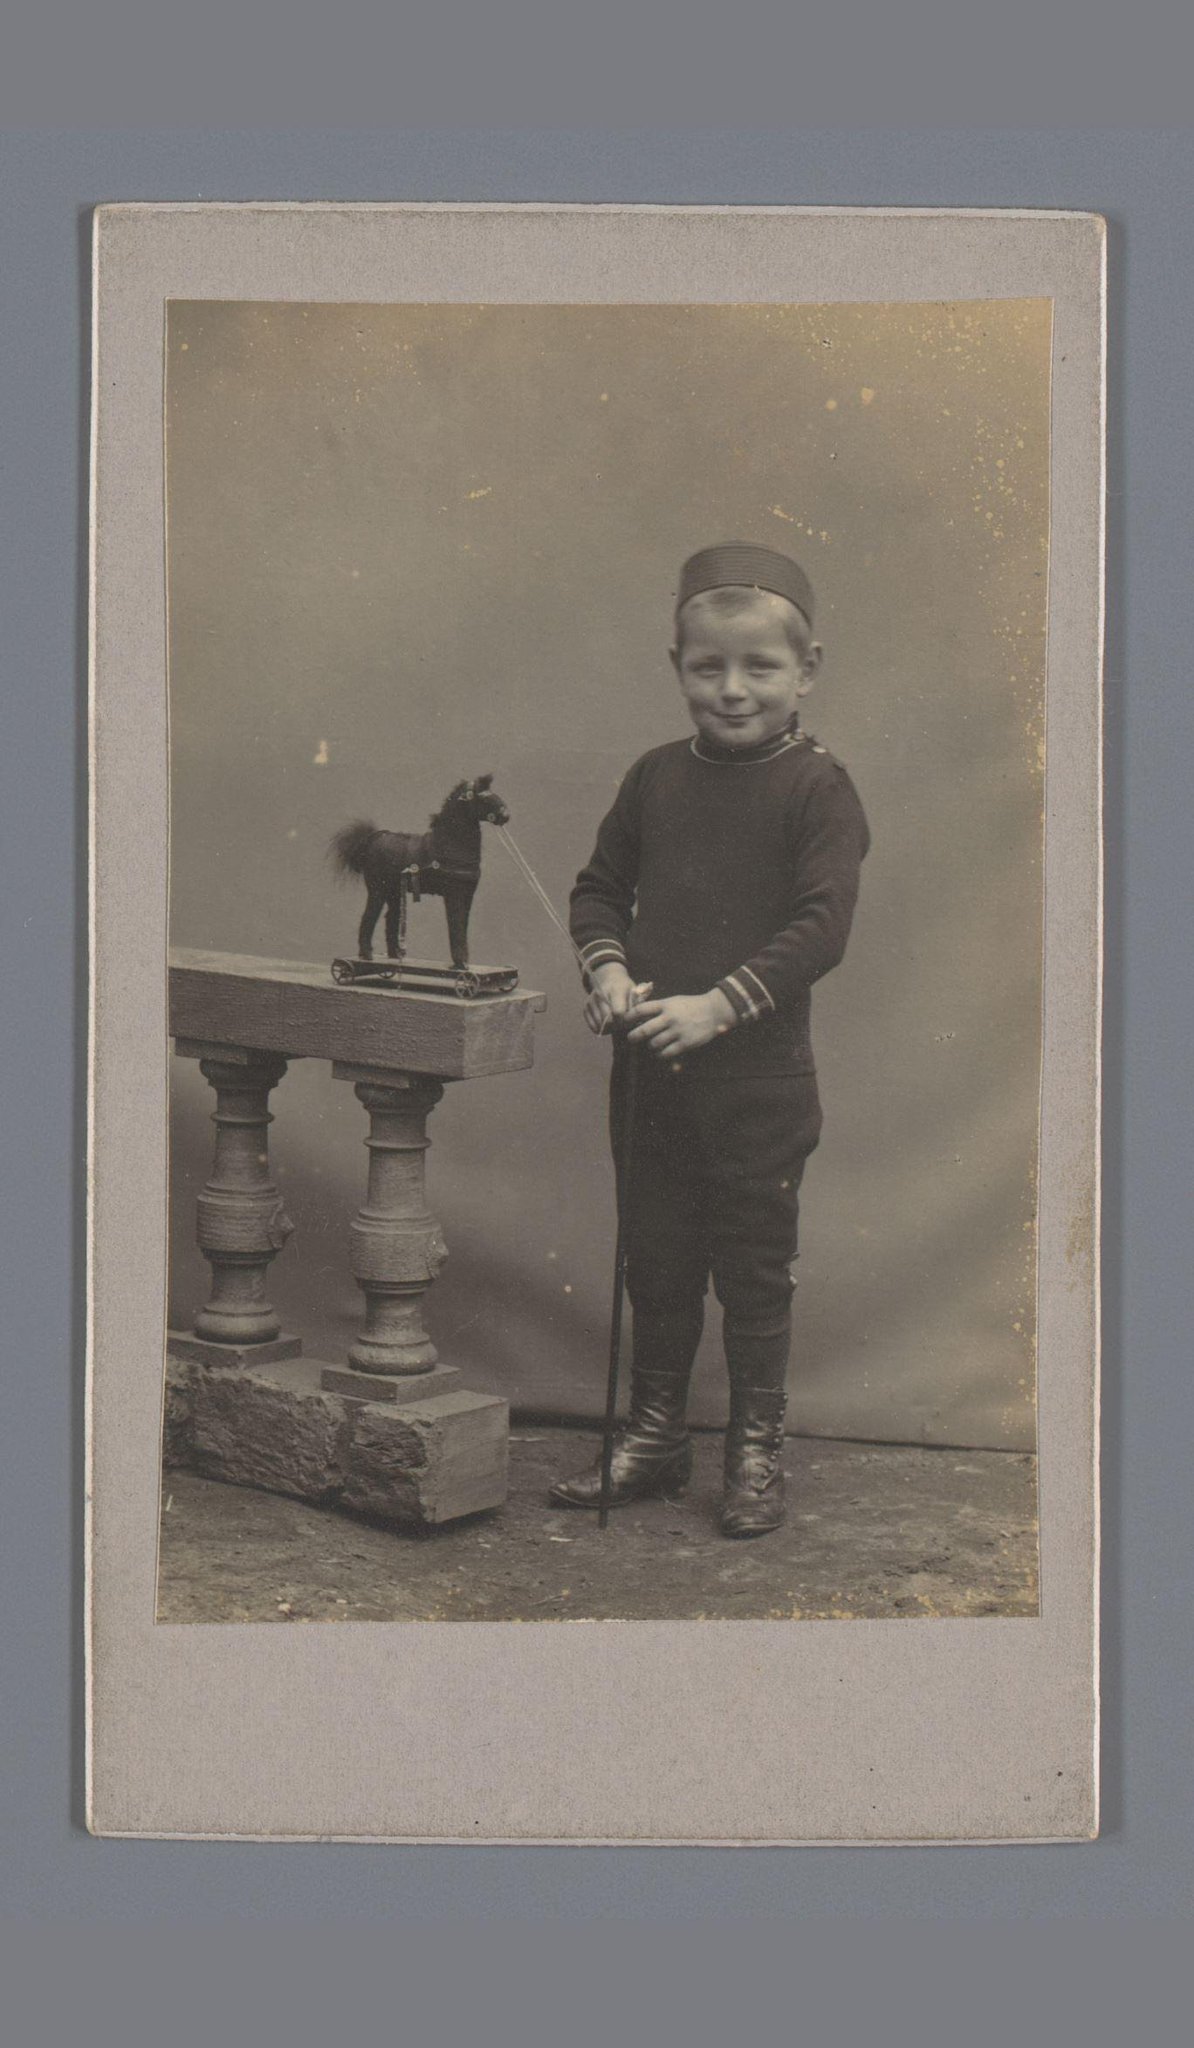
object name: photograph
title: Portret van Gerrit Looman met een speelgoedpaard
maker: Anonymous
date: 1900-1914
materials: paper, cardboard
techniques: gelatin silver print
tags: boy (child between toddler and youth), historical persons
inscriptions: name: ‘Gerrit Looman’